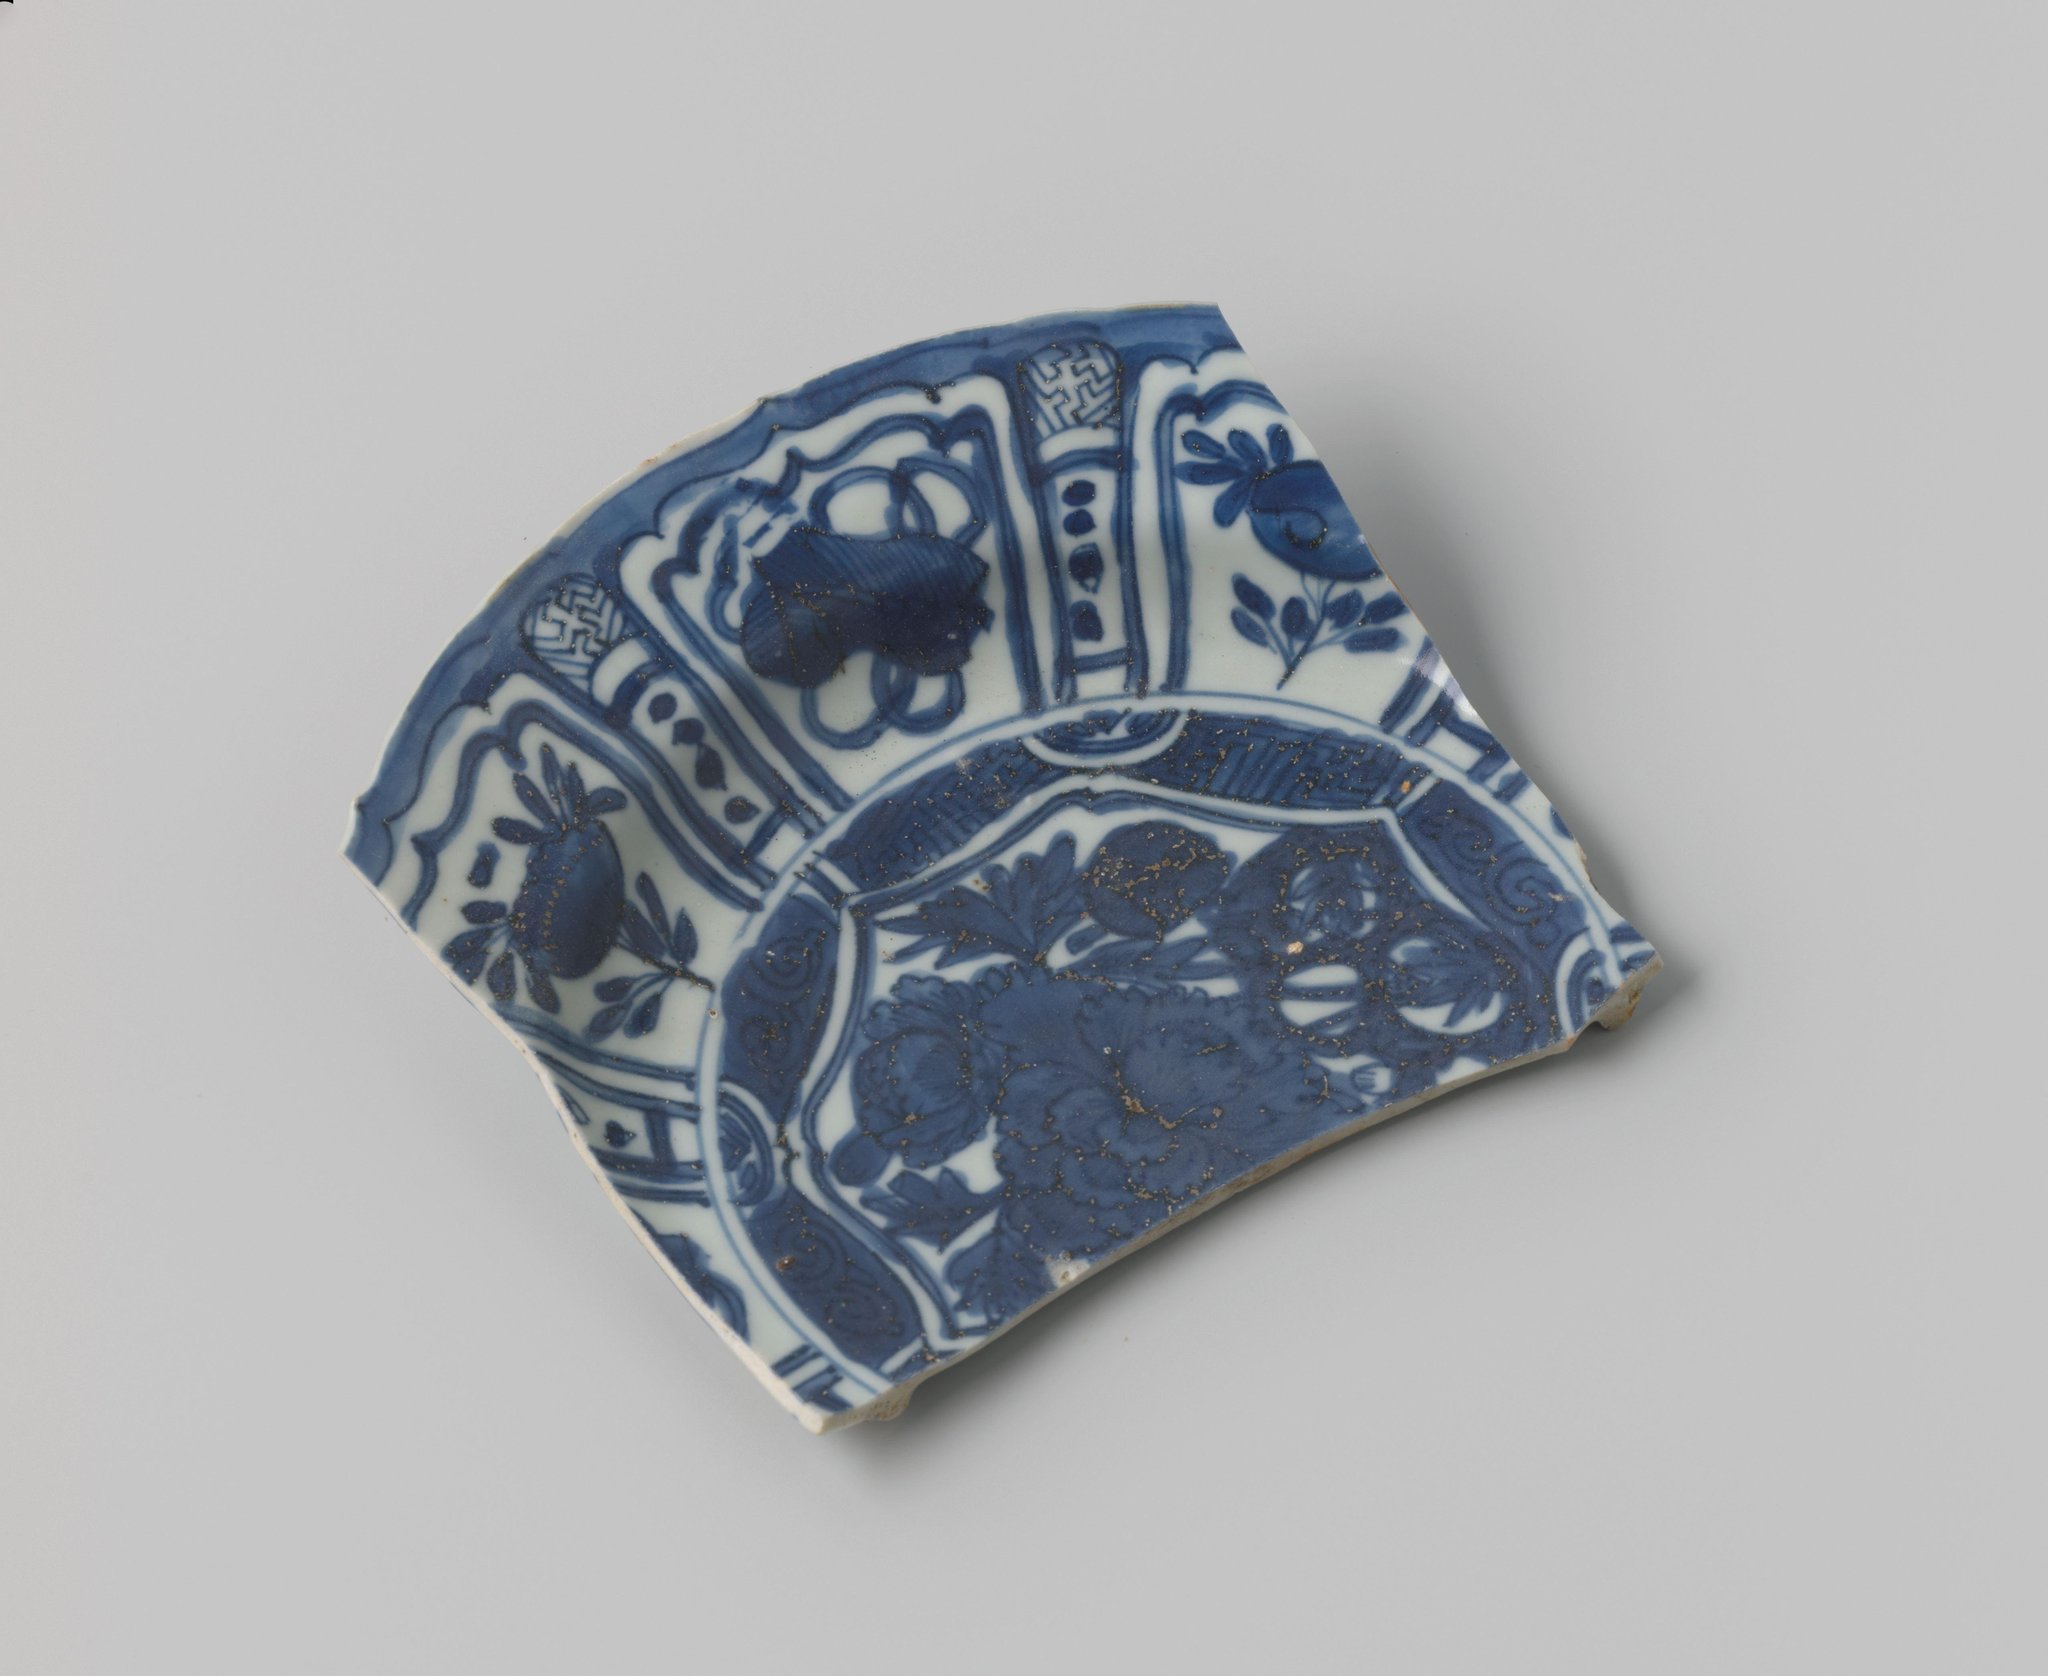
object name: sherd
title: Bord uit V.O.C.-schip de 'Witte Leeuw'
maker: Anonymous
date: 1613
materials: bone china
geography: jingdezhen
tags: verenigde oostindische compagnie, sint-helena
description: Bord uit V.O.C.-schip de 'Witte Leeuw', 50% aanwezig.